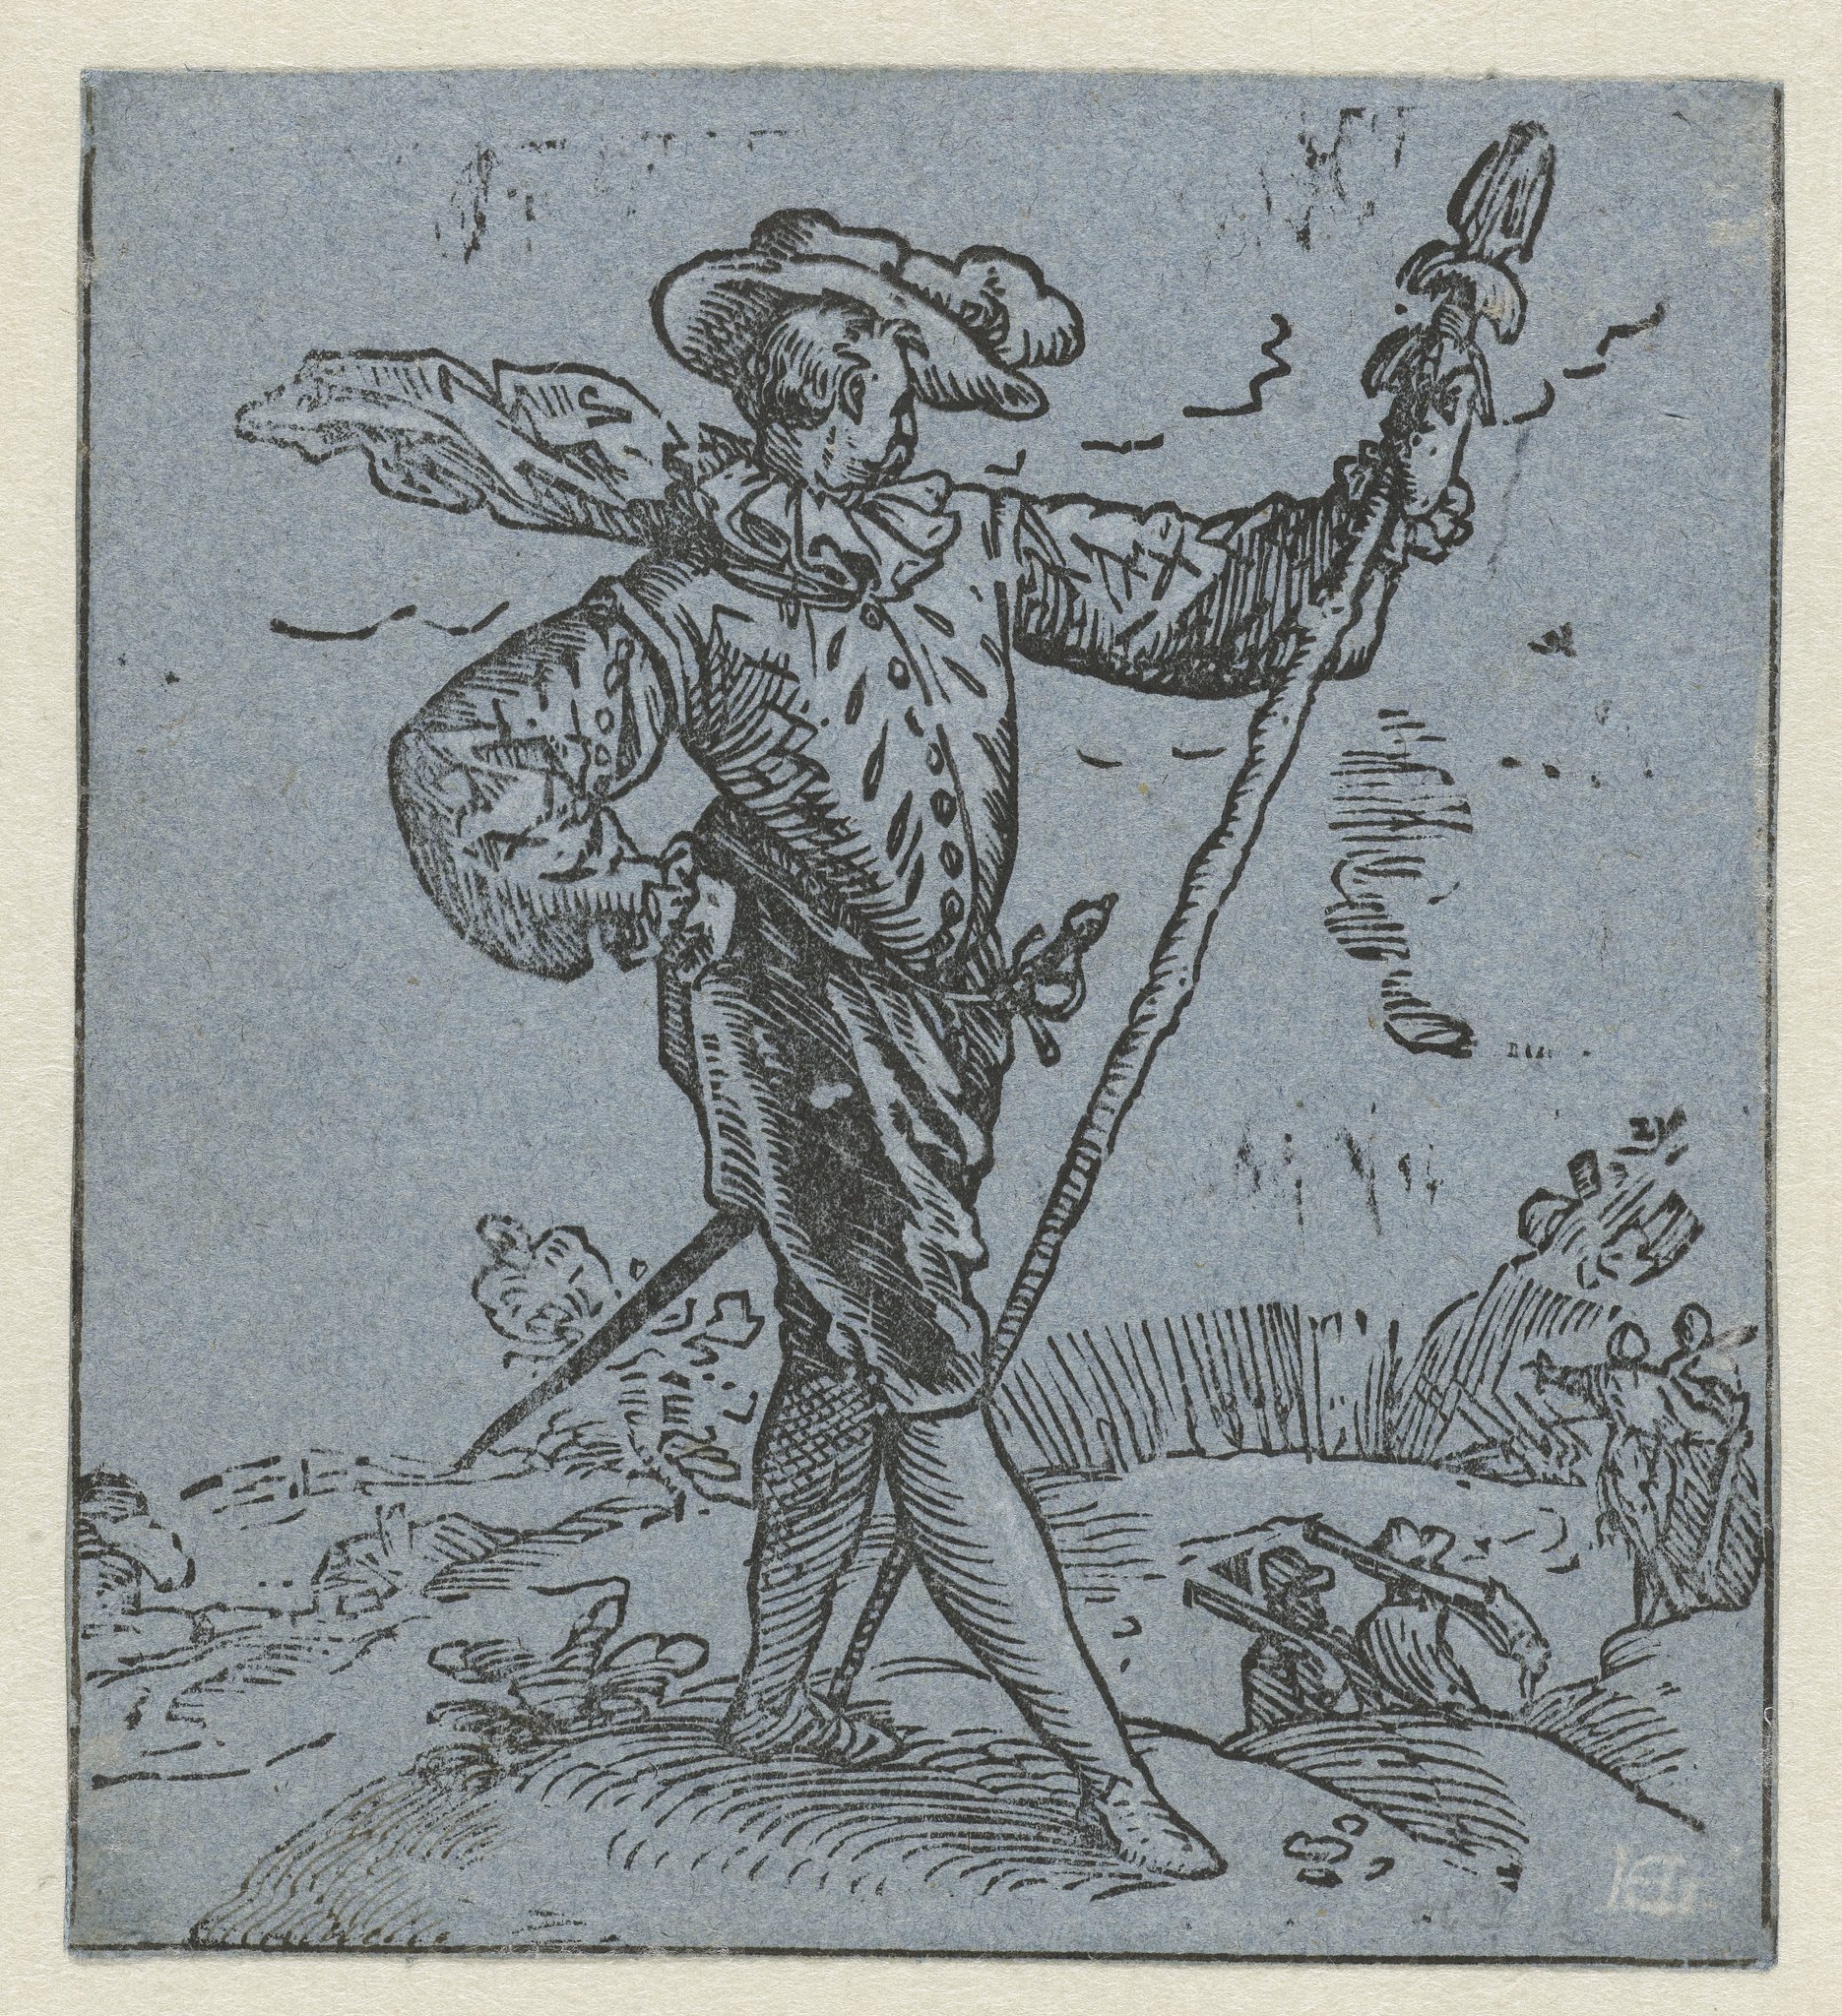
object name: print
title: Lansdrager, marcherend naar links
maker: hendrick goltzius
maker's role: draughtsman, painter, print maker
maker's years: 1558-1617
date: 1618-1622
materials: paint, paper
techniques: woodcut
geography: haarlem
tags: helved weapons, polearms (for striking, hacking, thrusting)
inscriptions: collector's mark: Lugt 2228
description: Een man met een partizaan (stokwapen) in zijn linkerhand. Ten voeten uit weergegeven, naar links lopend (naar rechts voor de beschouwer). Op de achtergrond infanteristen.